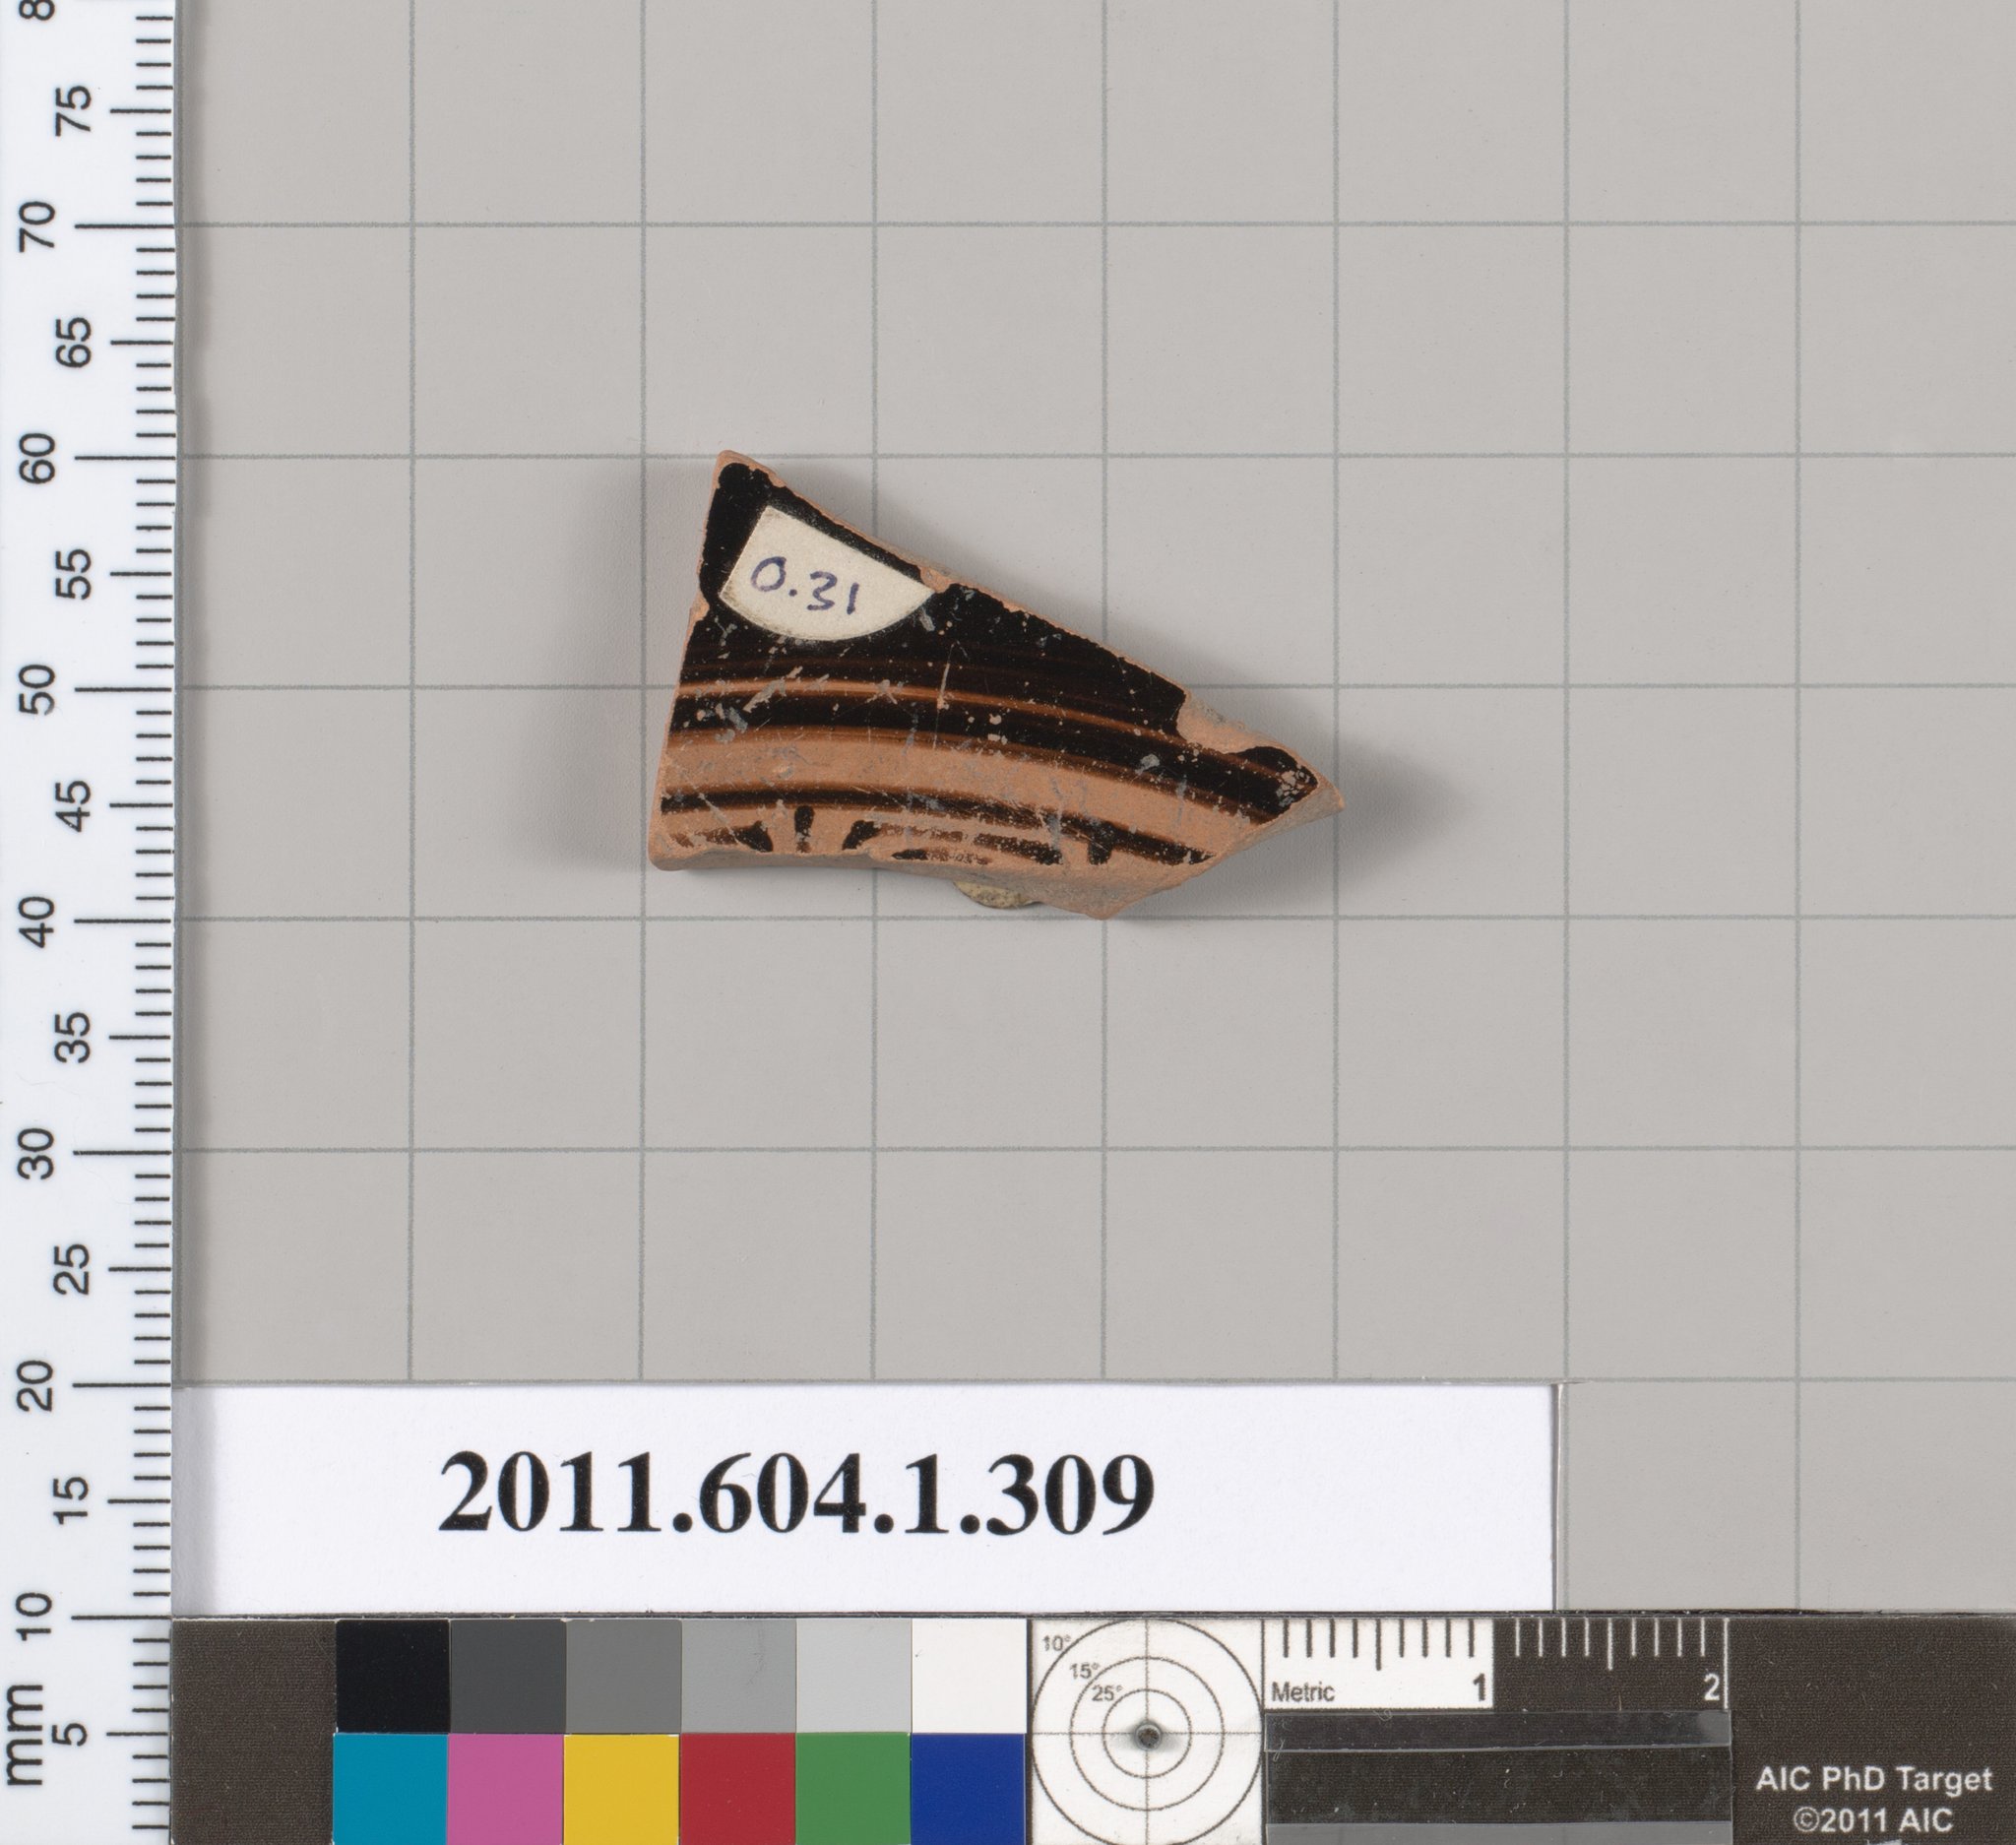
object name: kylix fragment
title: Terracotta fragment of a kylix (drinking cup)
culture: greek, attic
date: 475-451 BCE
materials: terracotta